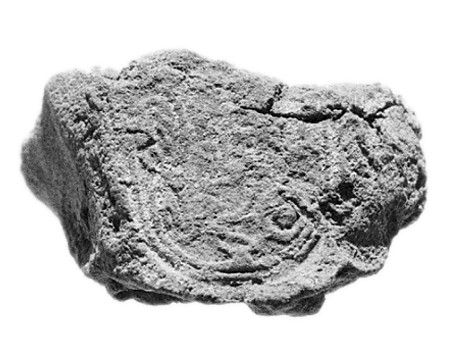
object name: sealing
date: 1981-1640 BCE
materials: mud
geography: egypt